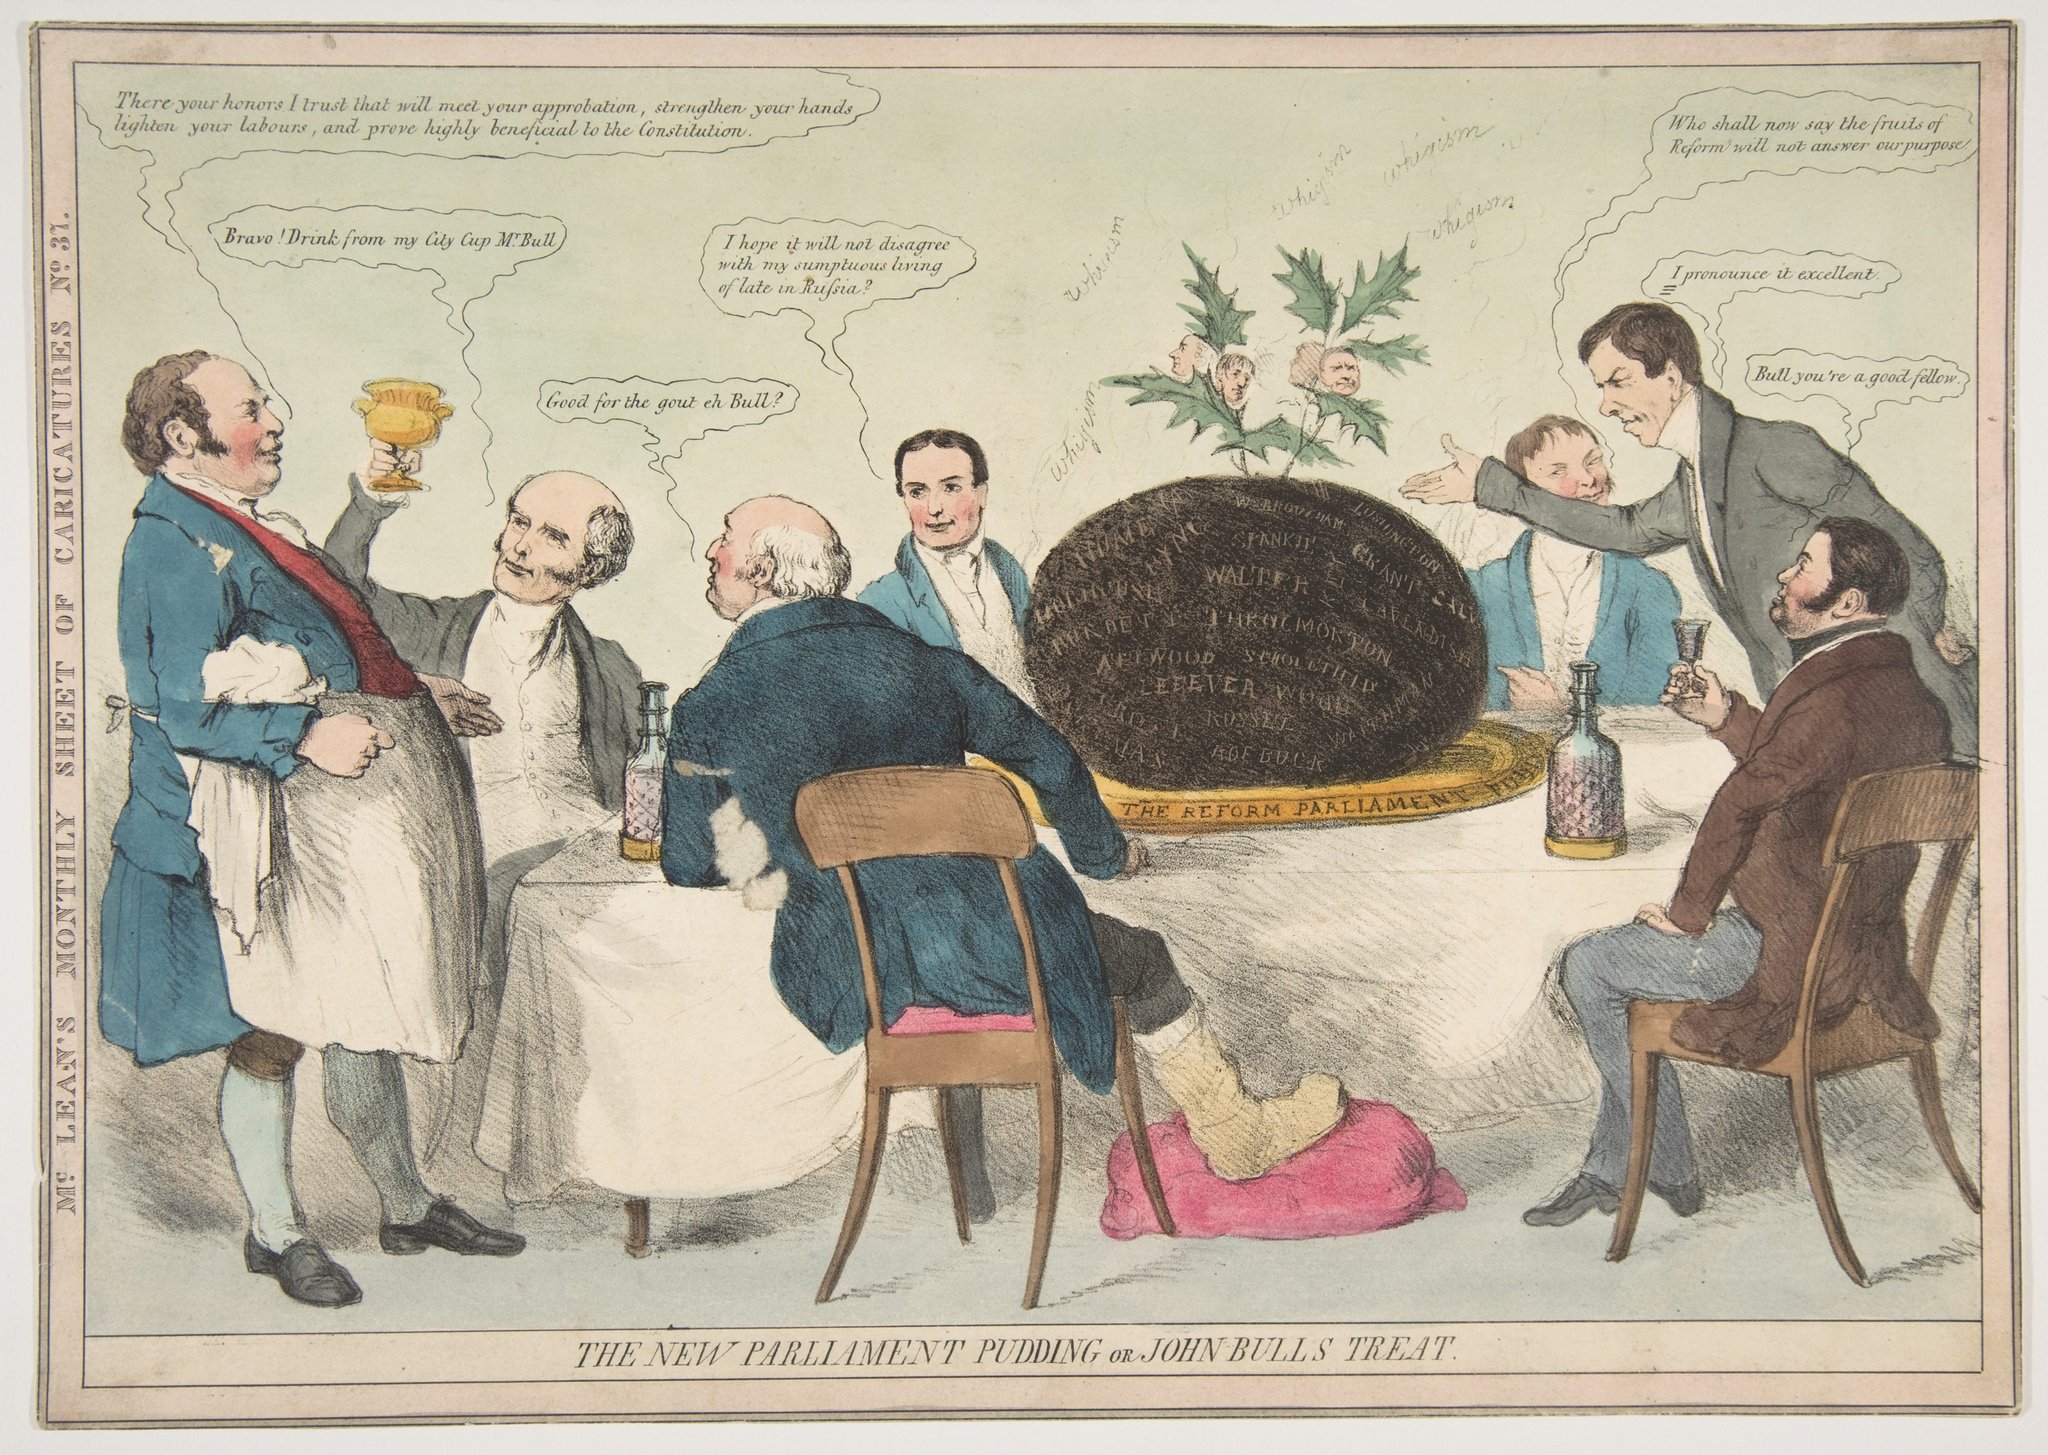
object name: print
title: The New Parliament Pudding or John Bull's Treat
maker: anonymous, british, 19th century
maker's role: artist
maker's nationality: british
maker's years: 1800-1900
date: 1832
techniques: hand coloring, lithograph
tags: satire,men,drinking,politics